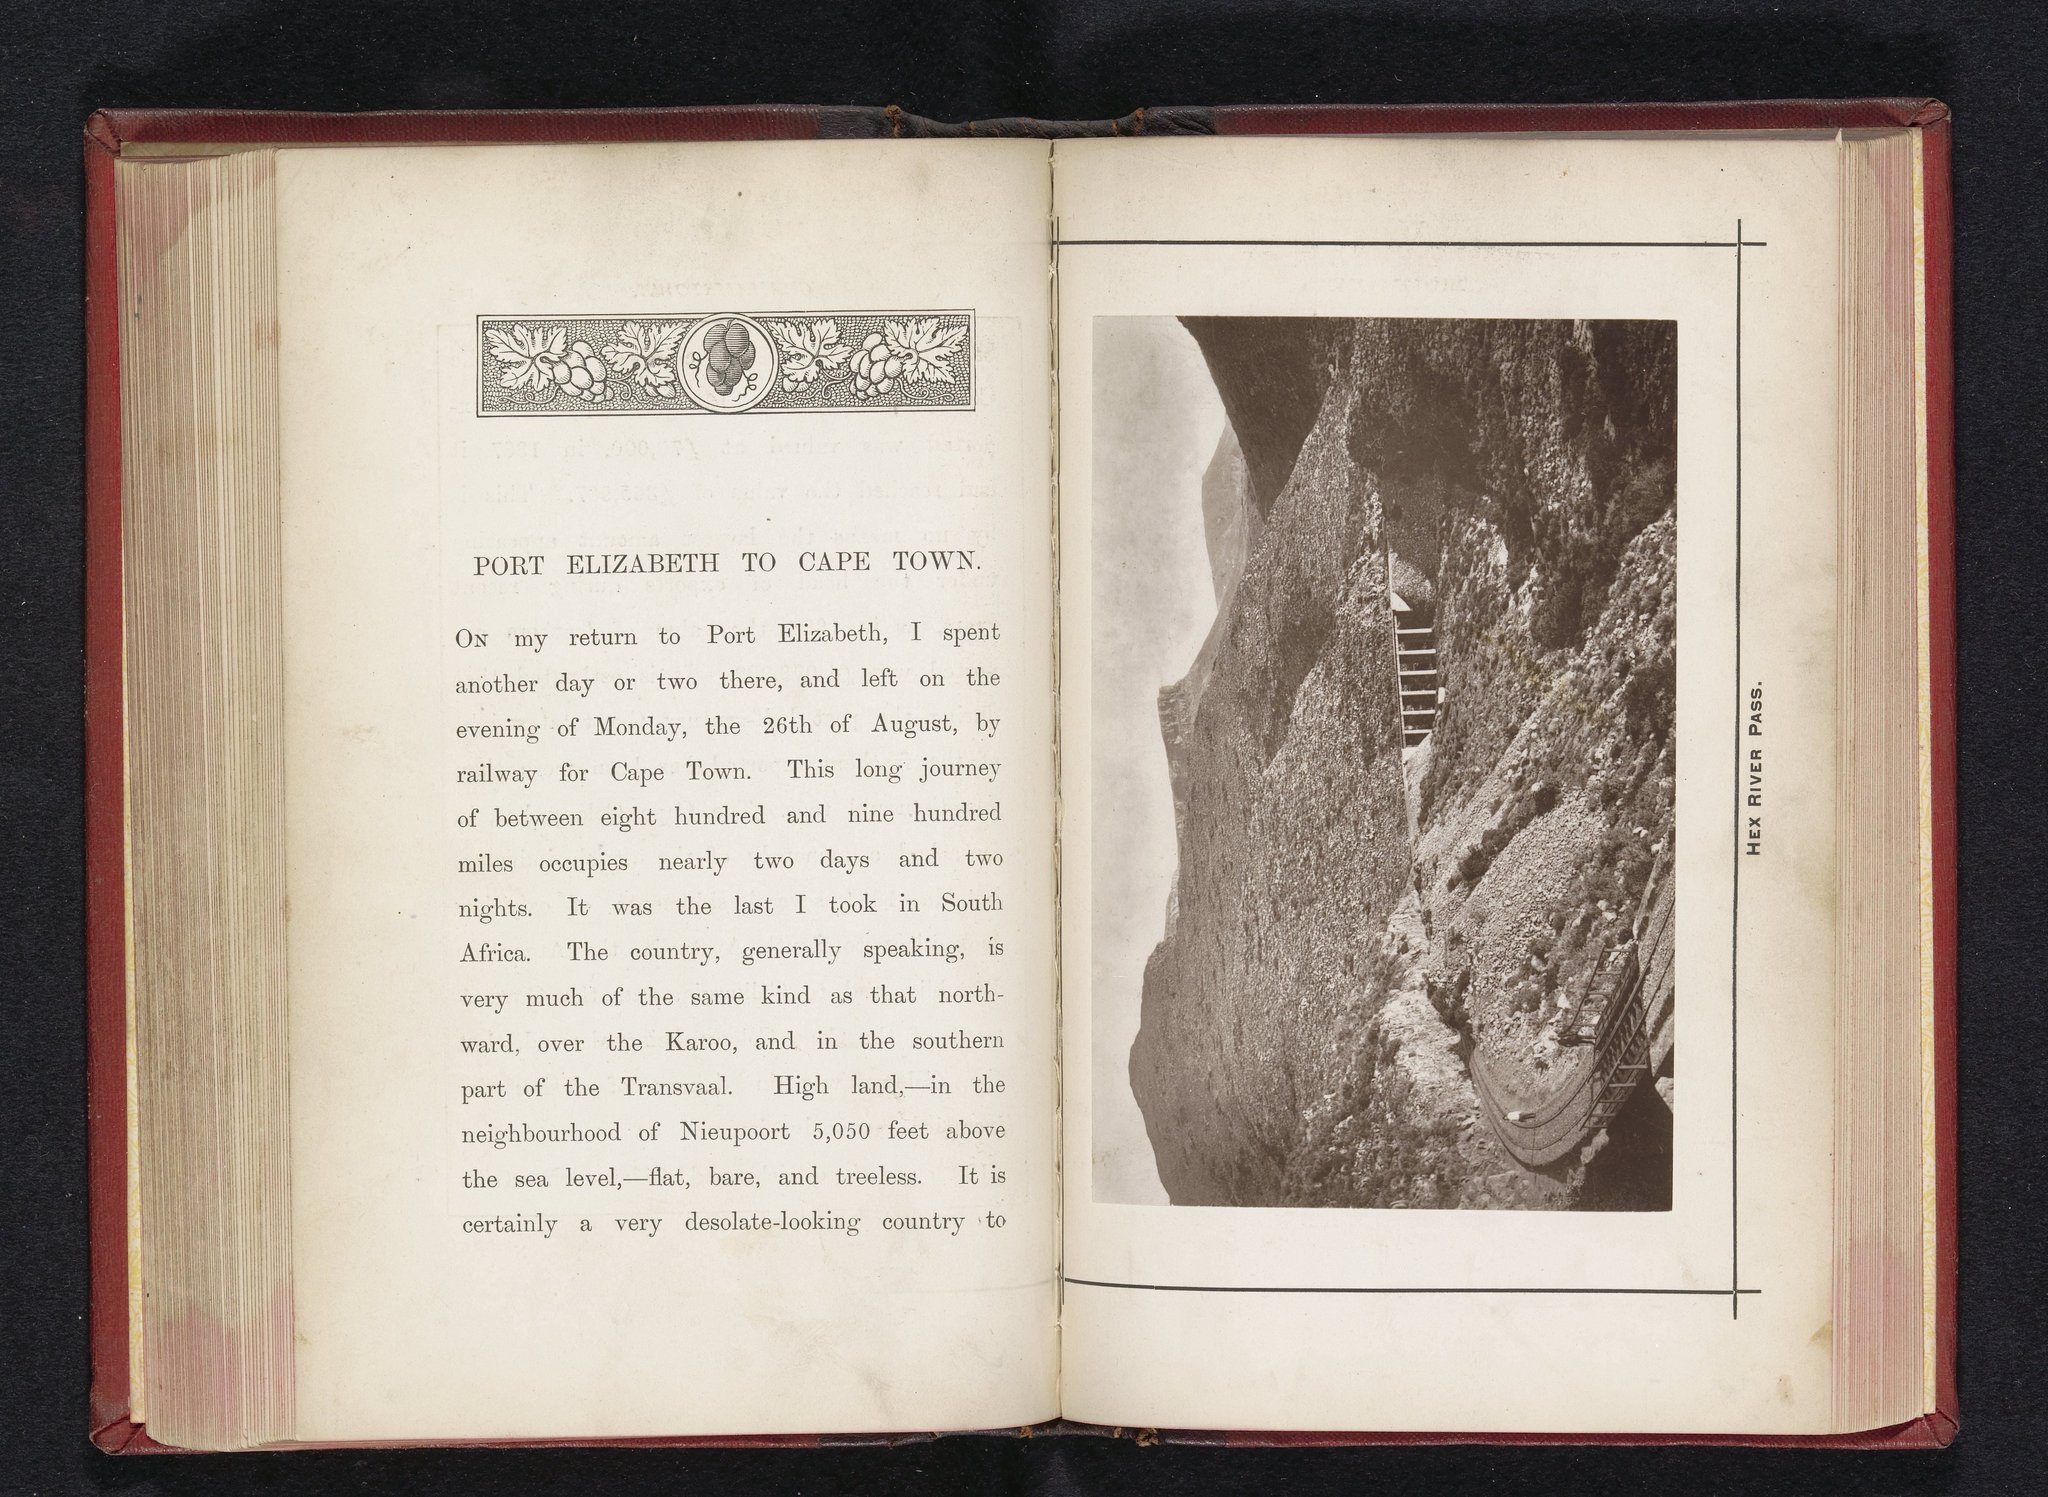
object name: photomechanical print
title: Treinspoor in de Hexrivierberge in Zuid-Afrika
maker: Anonymous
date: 1888-1890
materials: paper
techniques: woodburytype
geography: south africa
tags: railway, train